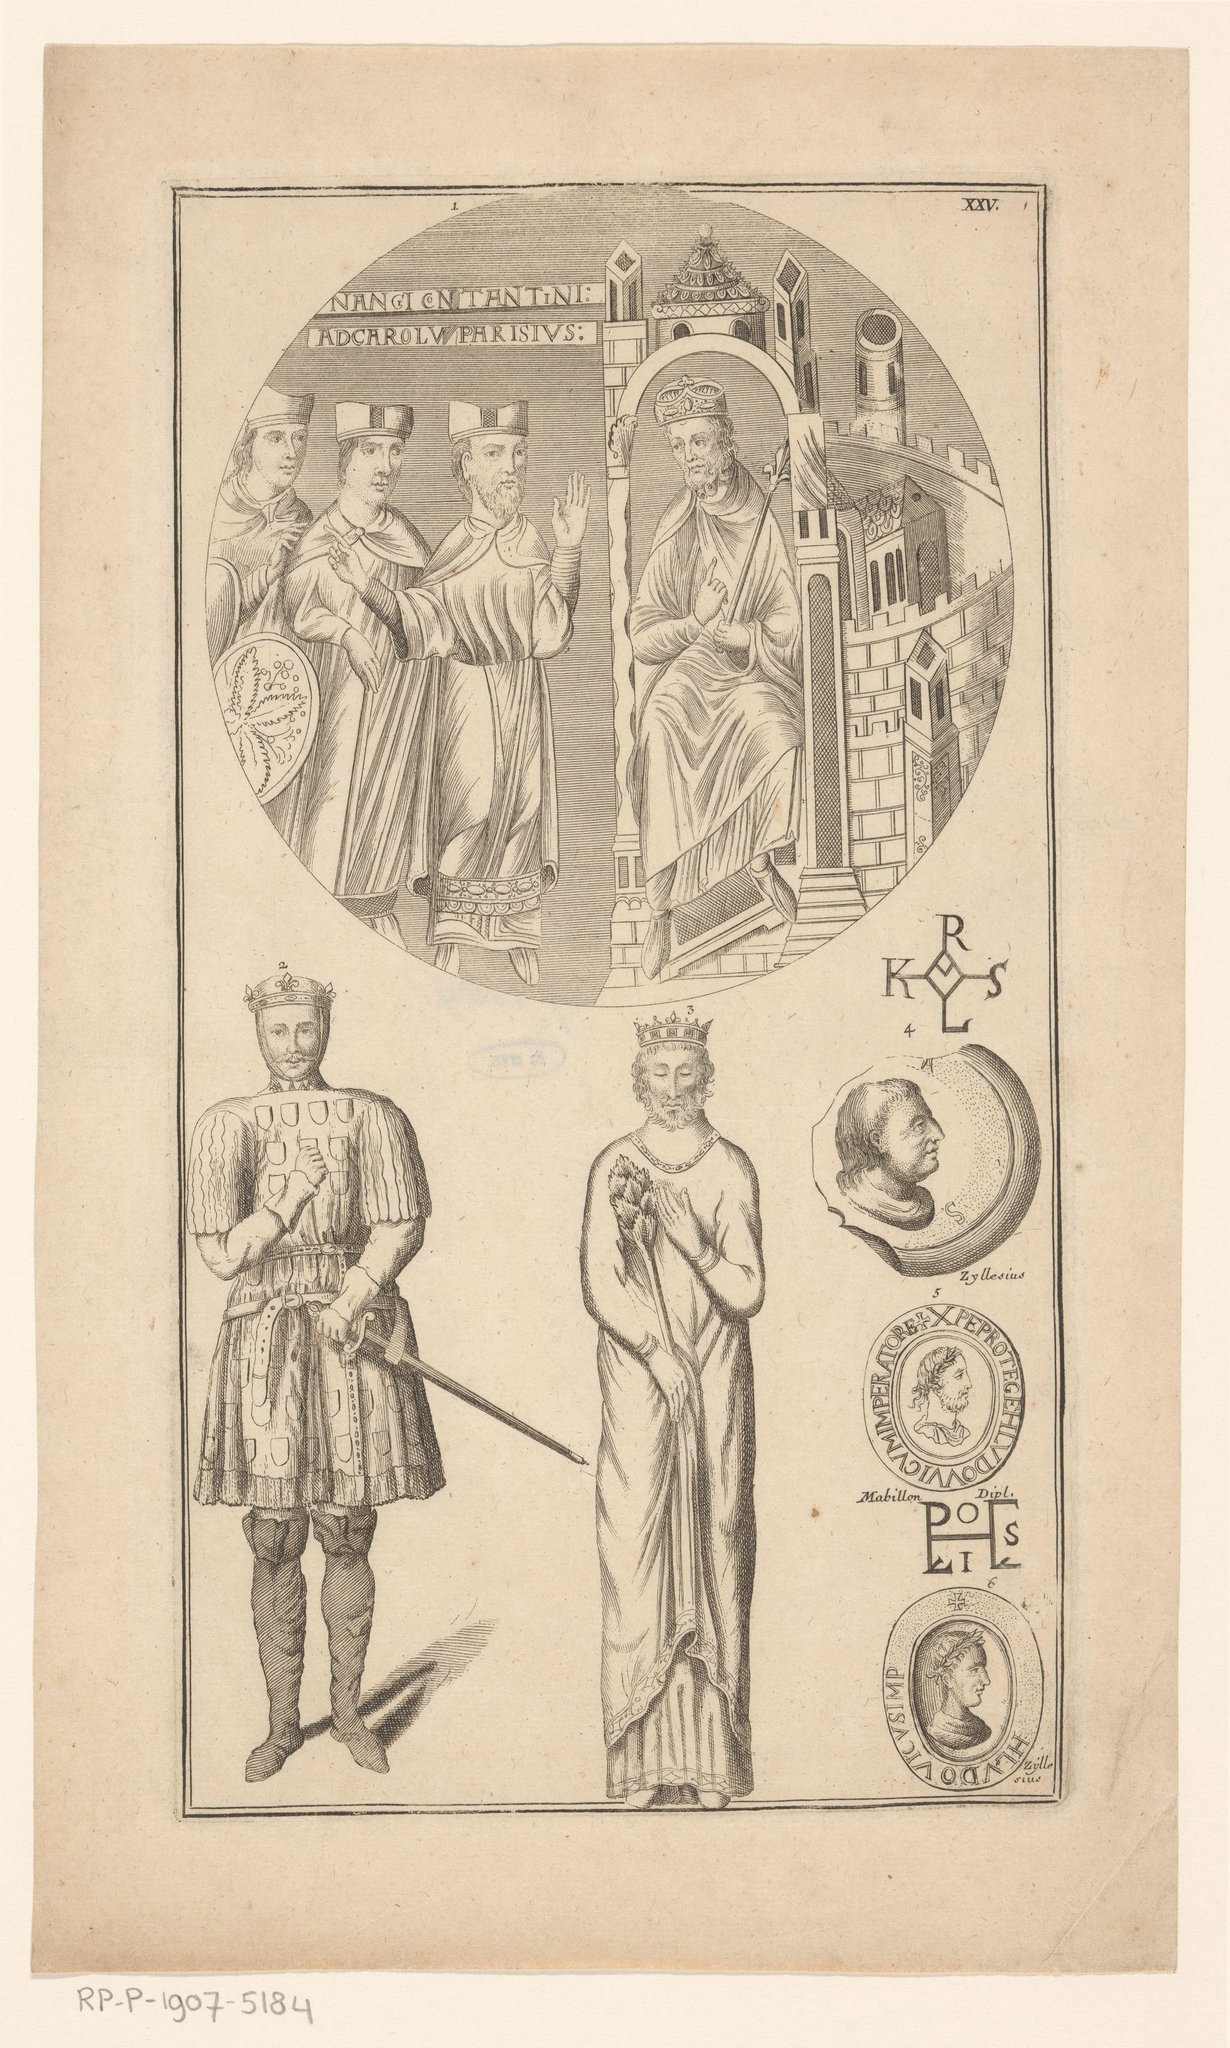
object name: print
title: Diverse portretten van koningen en koninklijke zegels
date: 1729-1733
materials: paper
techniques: engraving, etching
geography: paris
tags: charlemagne (holy roman emperor), emperor, the holy roman emperor charlemagne; possible attributes: crown, model of church, orb, sceptre, sword, king, nobility and patriciate; chivalry, knighthood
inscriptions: collector's mark: Lugt 2228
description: Prent uit: Montfaucon, Bernard de. Les monumens de la monarchie françoise, qui comprennent l'histoire de France avec les figures de chaque règne que l'injure des tems a épargnées (...). Parijs: Julien-Michel Gandouin en Pierre-François Giffart, 1729-1733, dl. 1, afb. voor p. 279.